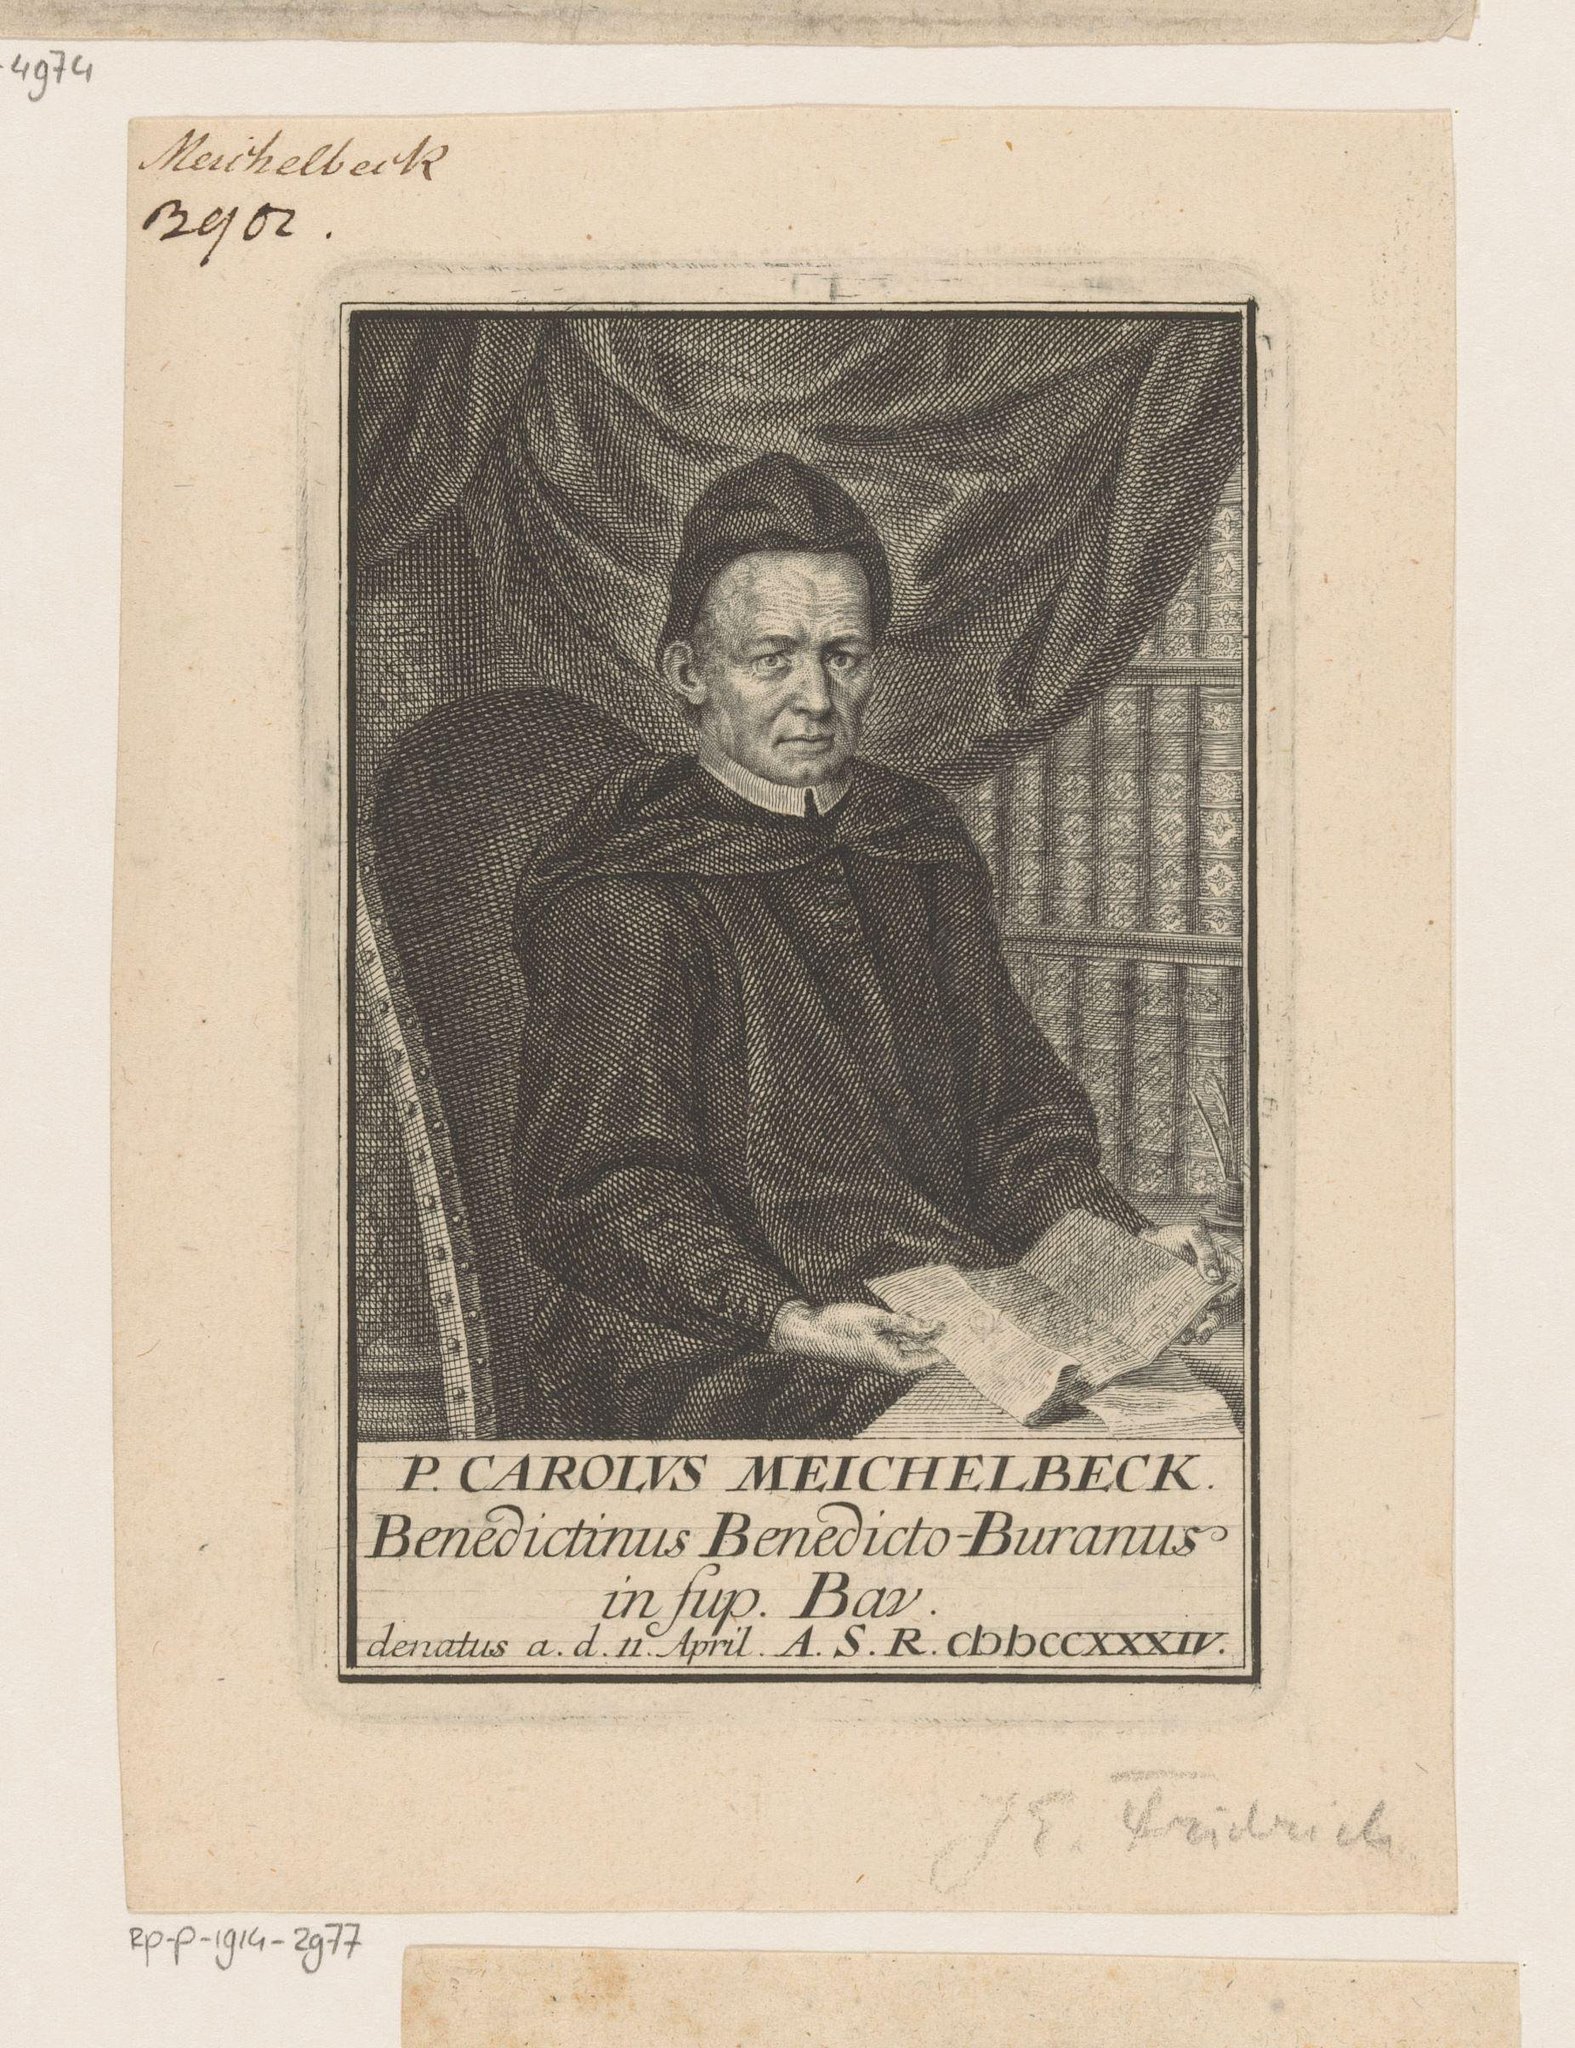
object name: print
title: Portret van Karl Meichelbeck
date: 1734-1751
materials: paper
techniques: engraving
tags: bookshelves, historical persons, letter, envelope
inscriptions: collector's mark: Lugt 2228